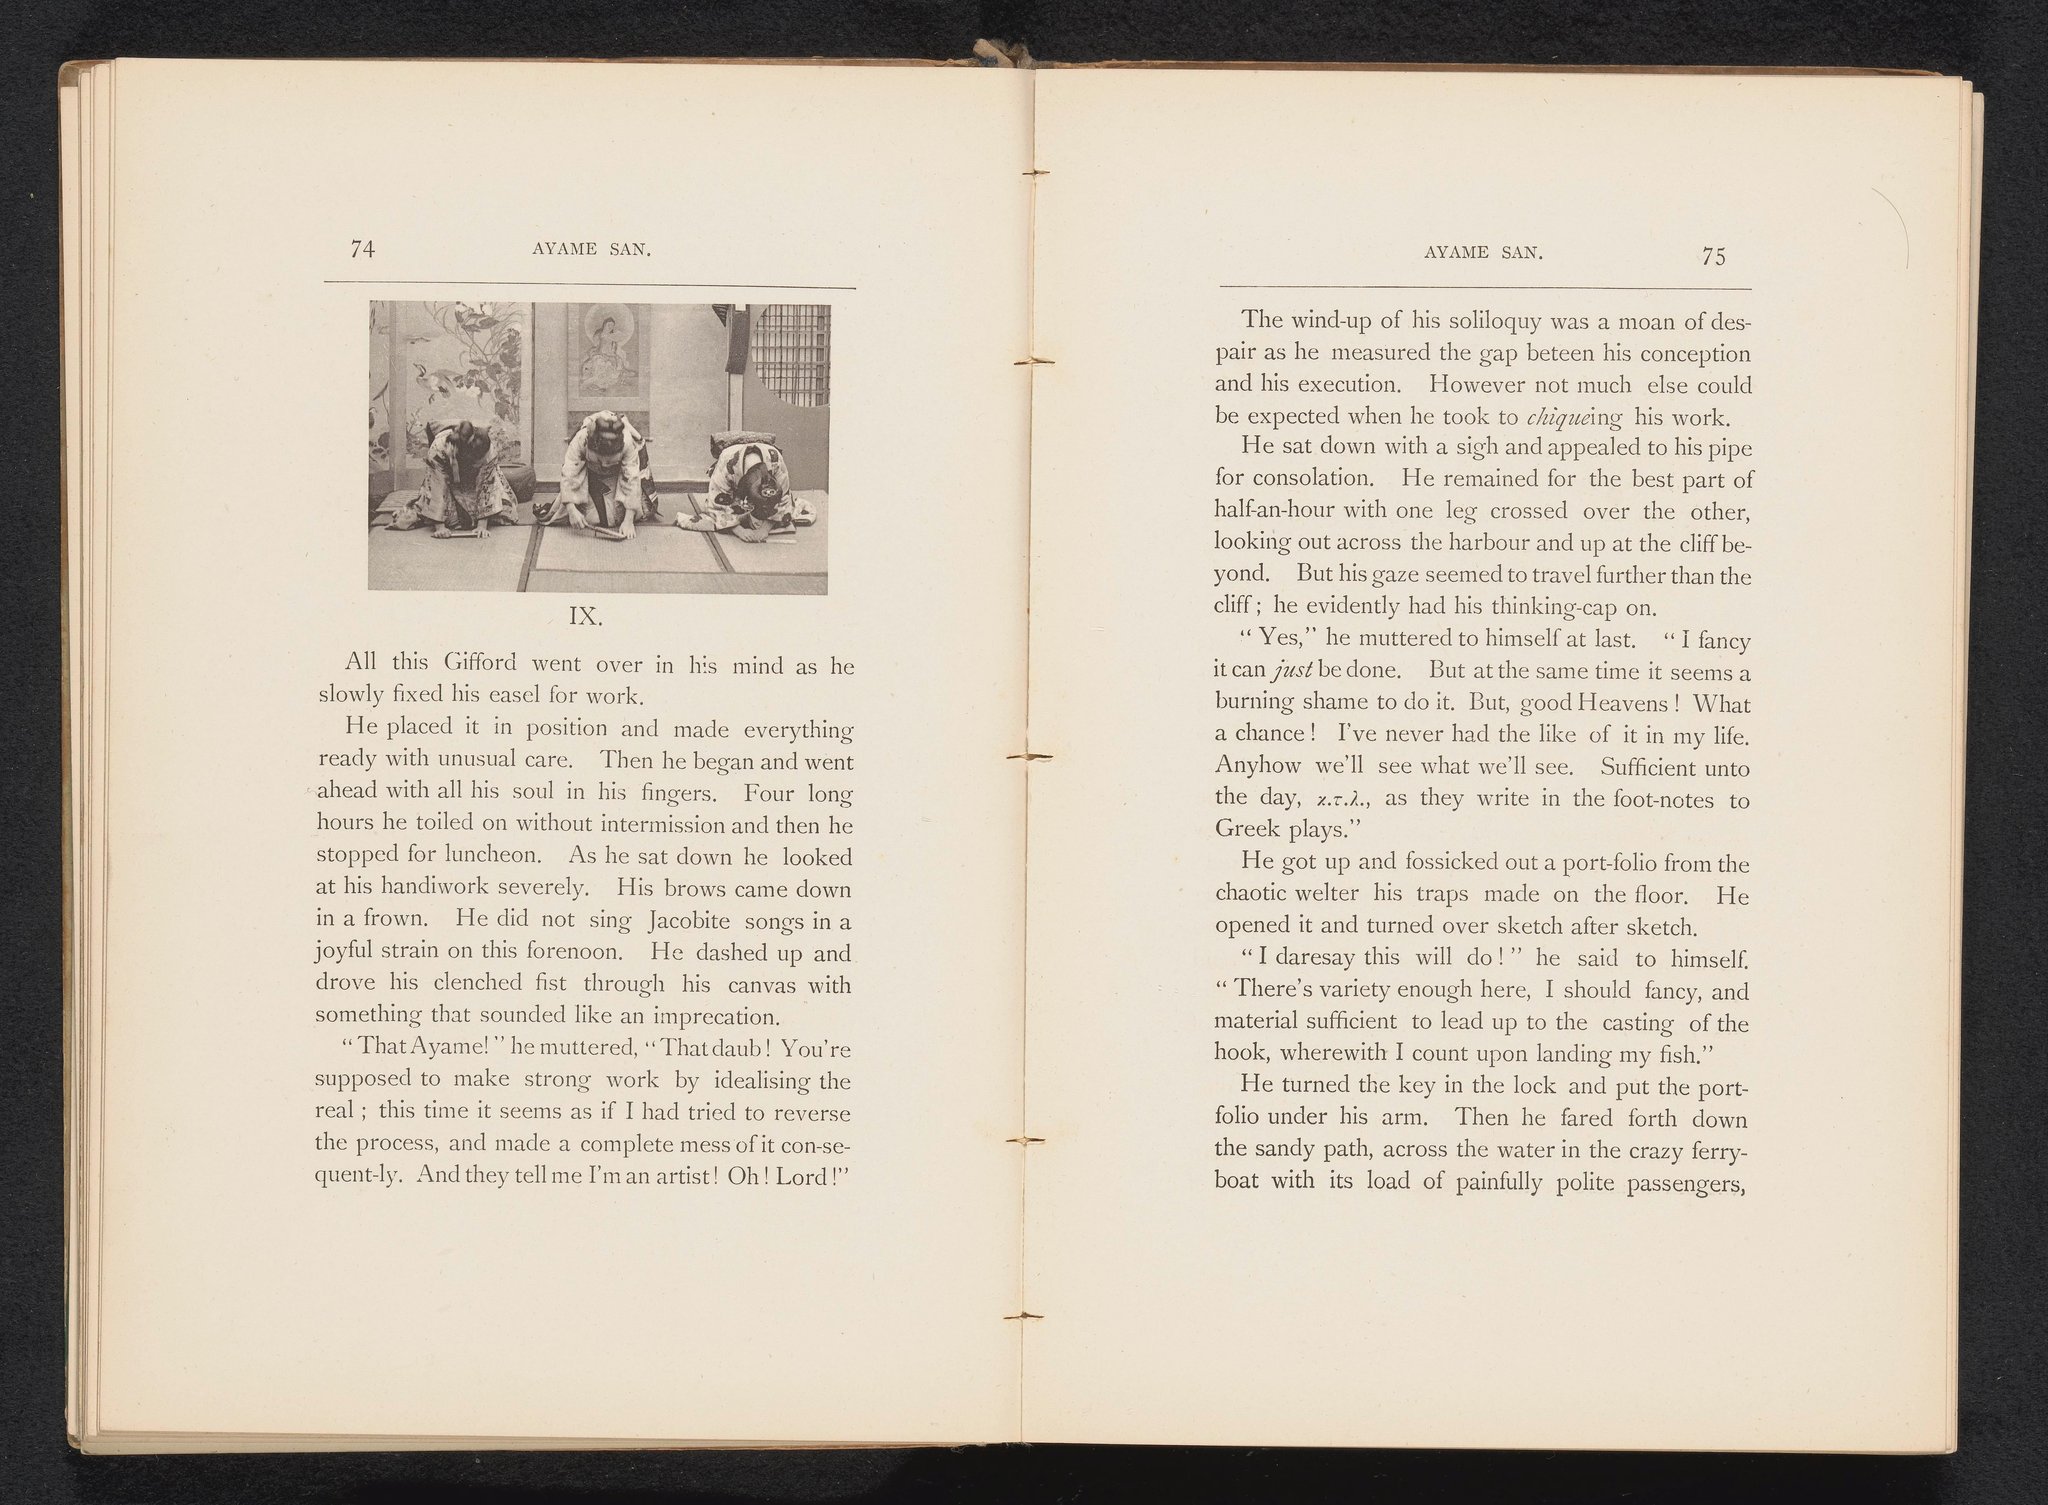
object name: photomechanical print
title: Drie knielende vrouwen in een interieur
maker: kazumasa ogawa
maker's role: auteur, fotograaf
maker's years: 1860-1929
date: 1882-1892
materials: paper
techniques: photograph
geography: japan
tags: interior ~ representation of a building, kneeling on both knees